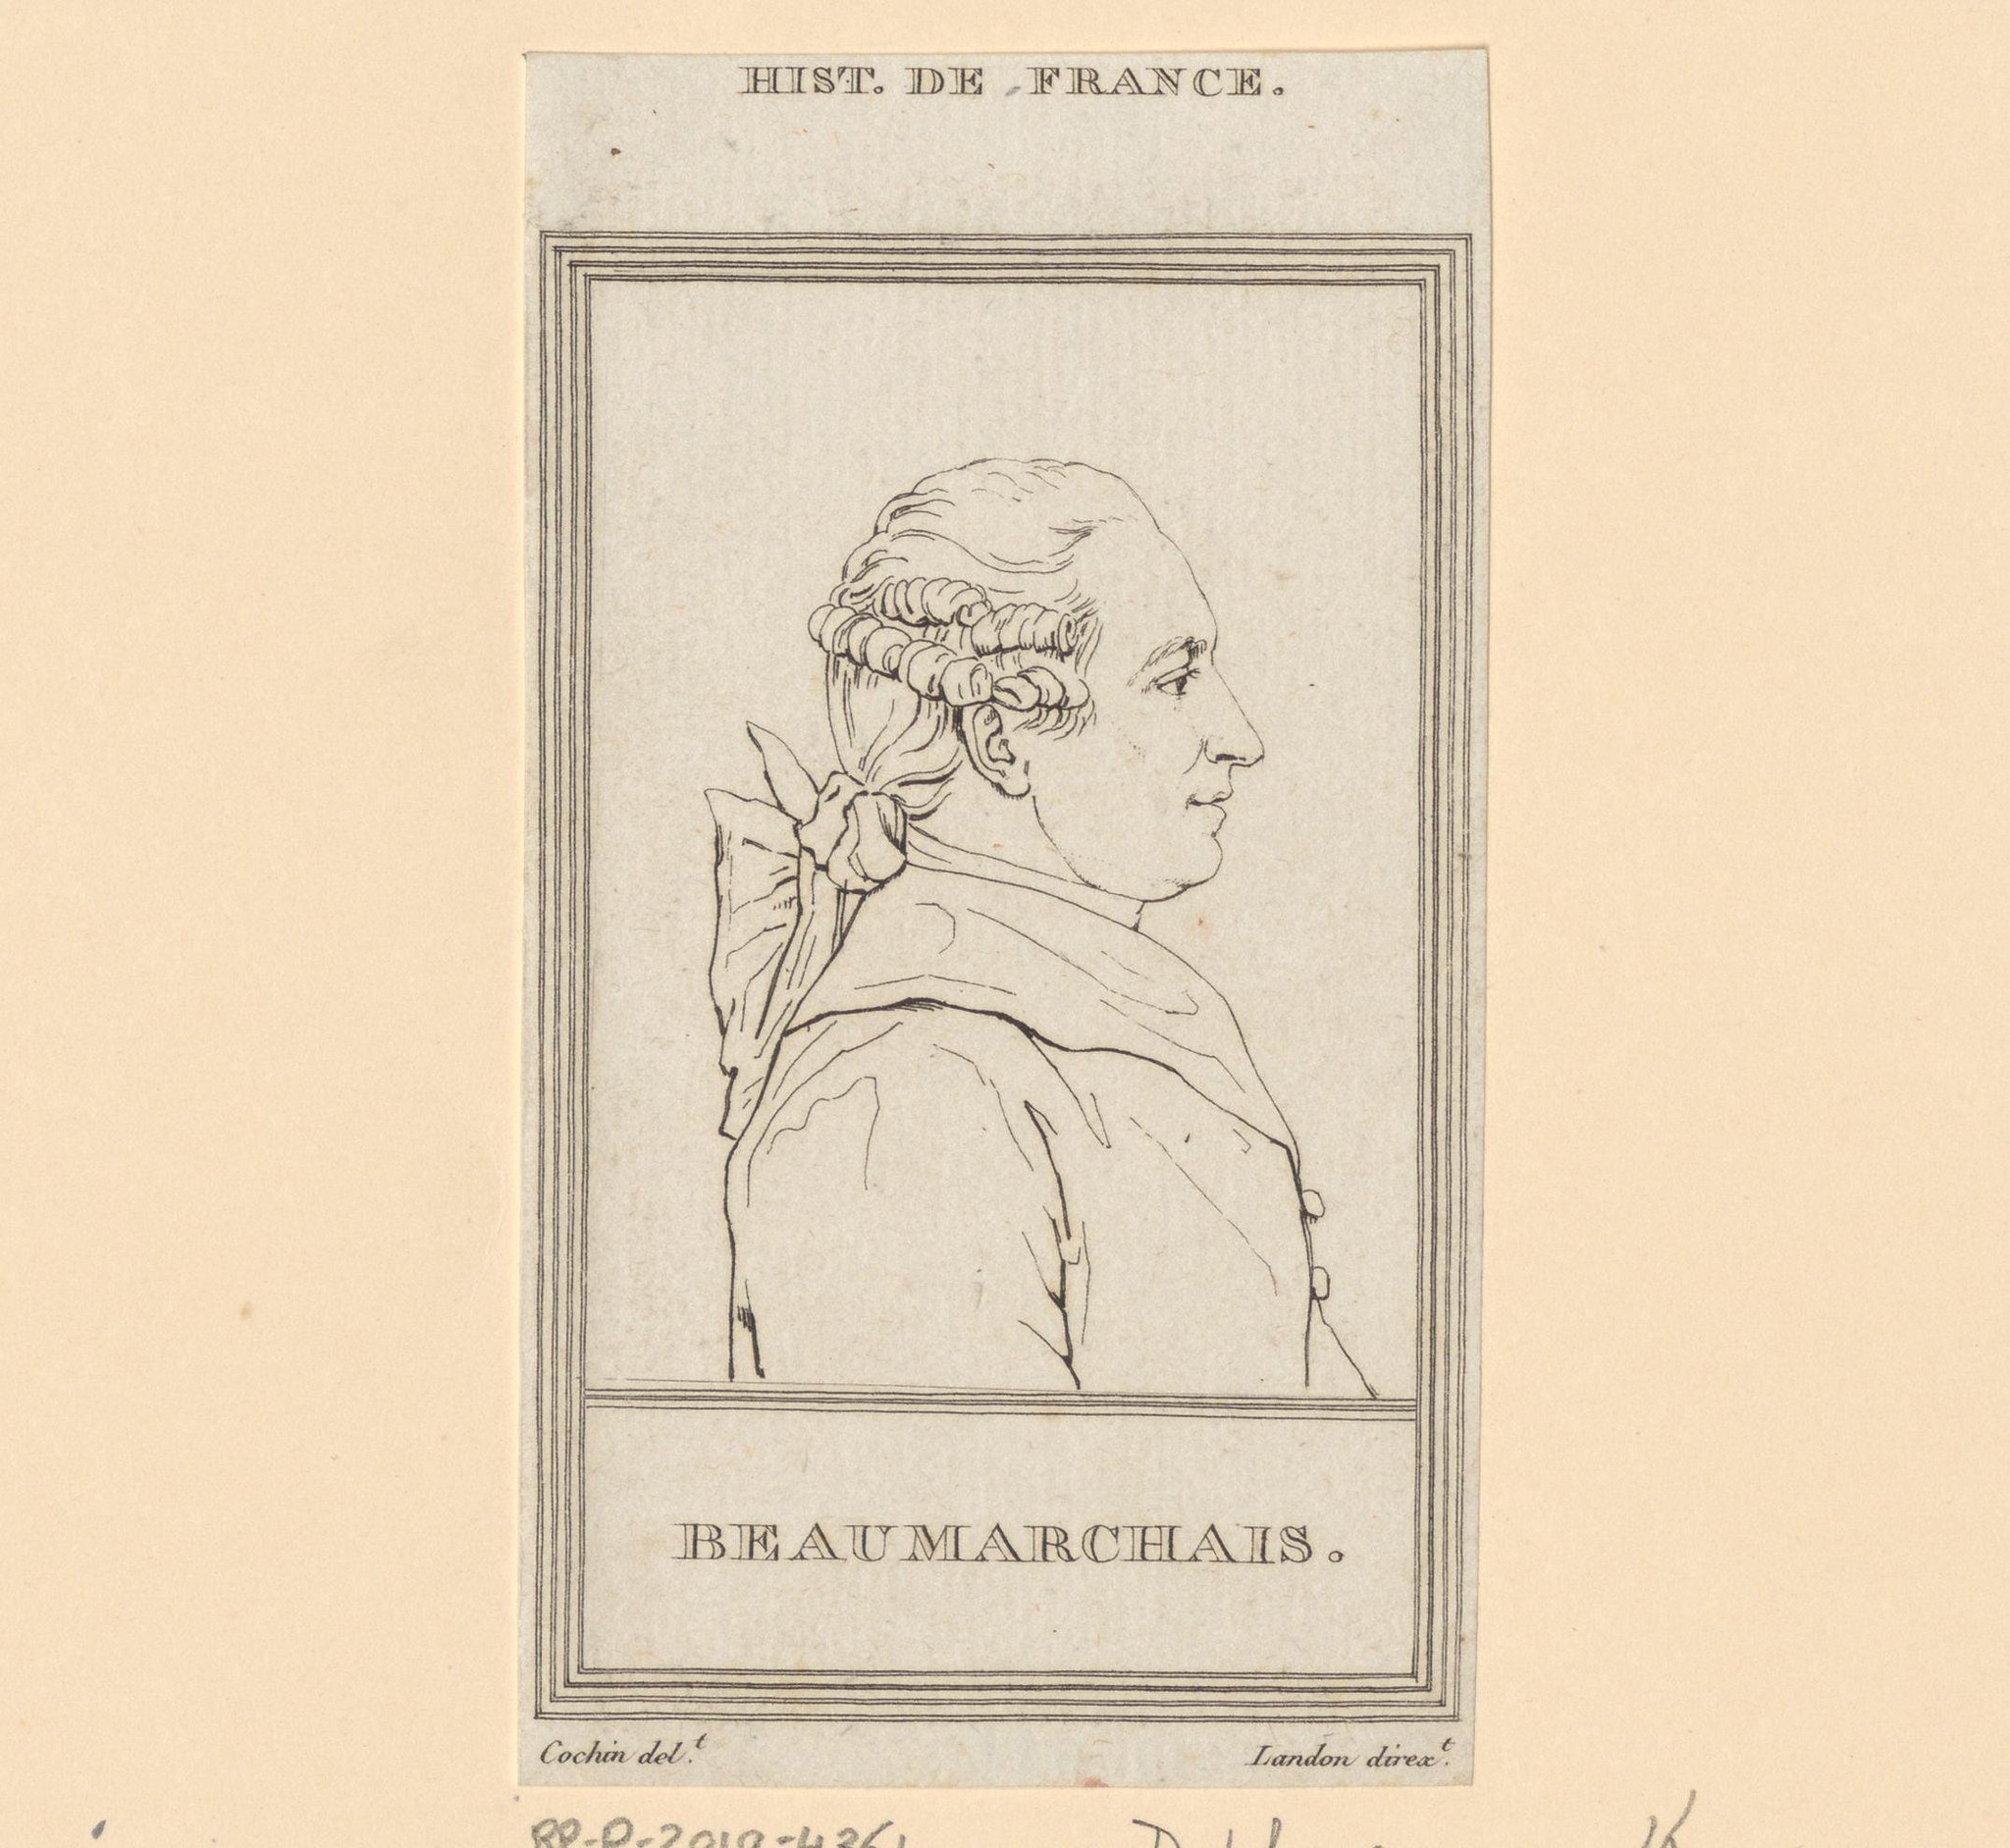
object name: print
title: Portret van Pierre Beaumarchais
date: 1805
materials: paper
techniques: etching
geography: paris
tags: historical persons, portrait of a writer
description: Prent uit: Galerie historique des hommes les plus célèbres (...). Parijs: Charles Paul Landon, 1805, dl. 2.